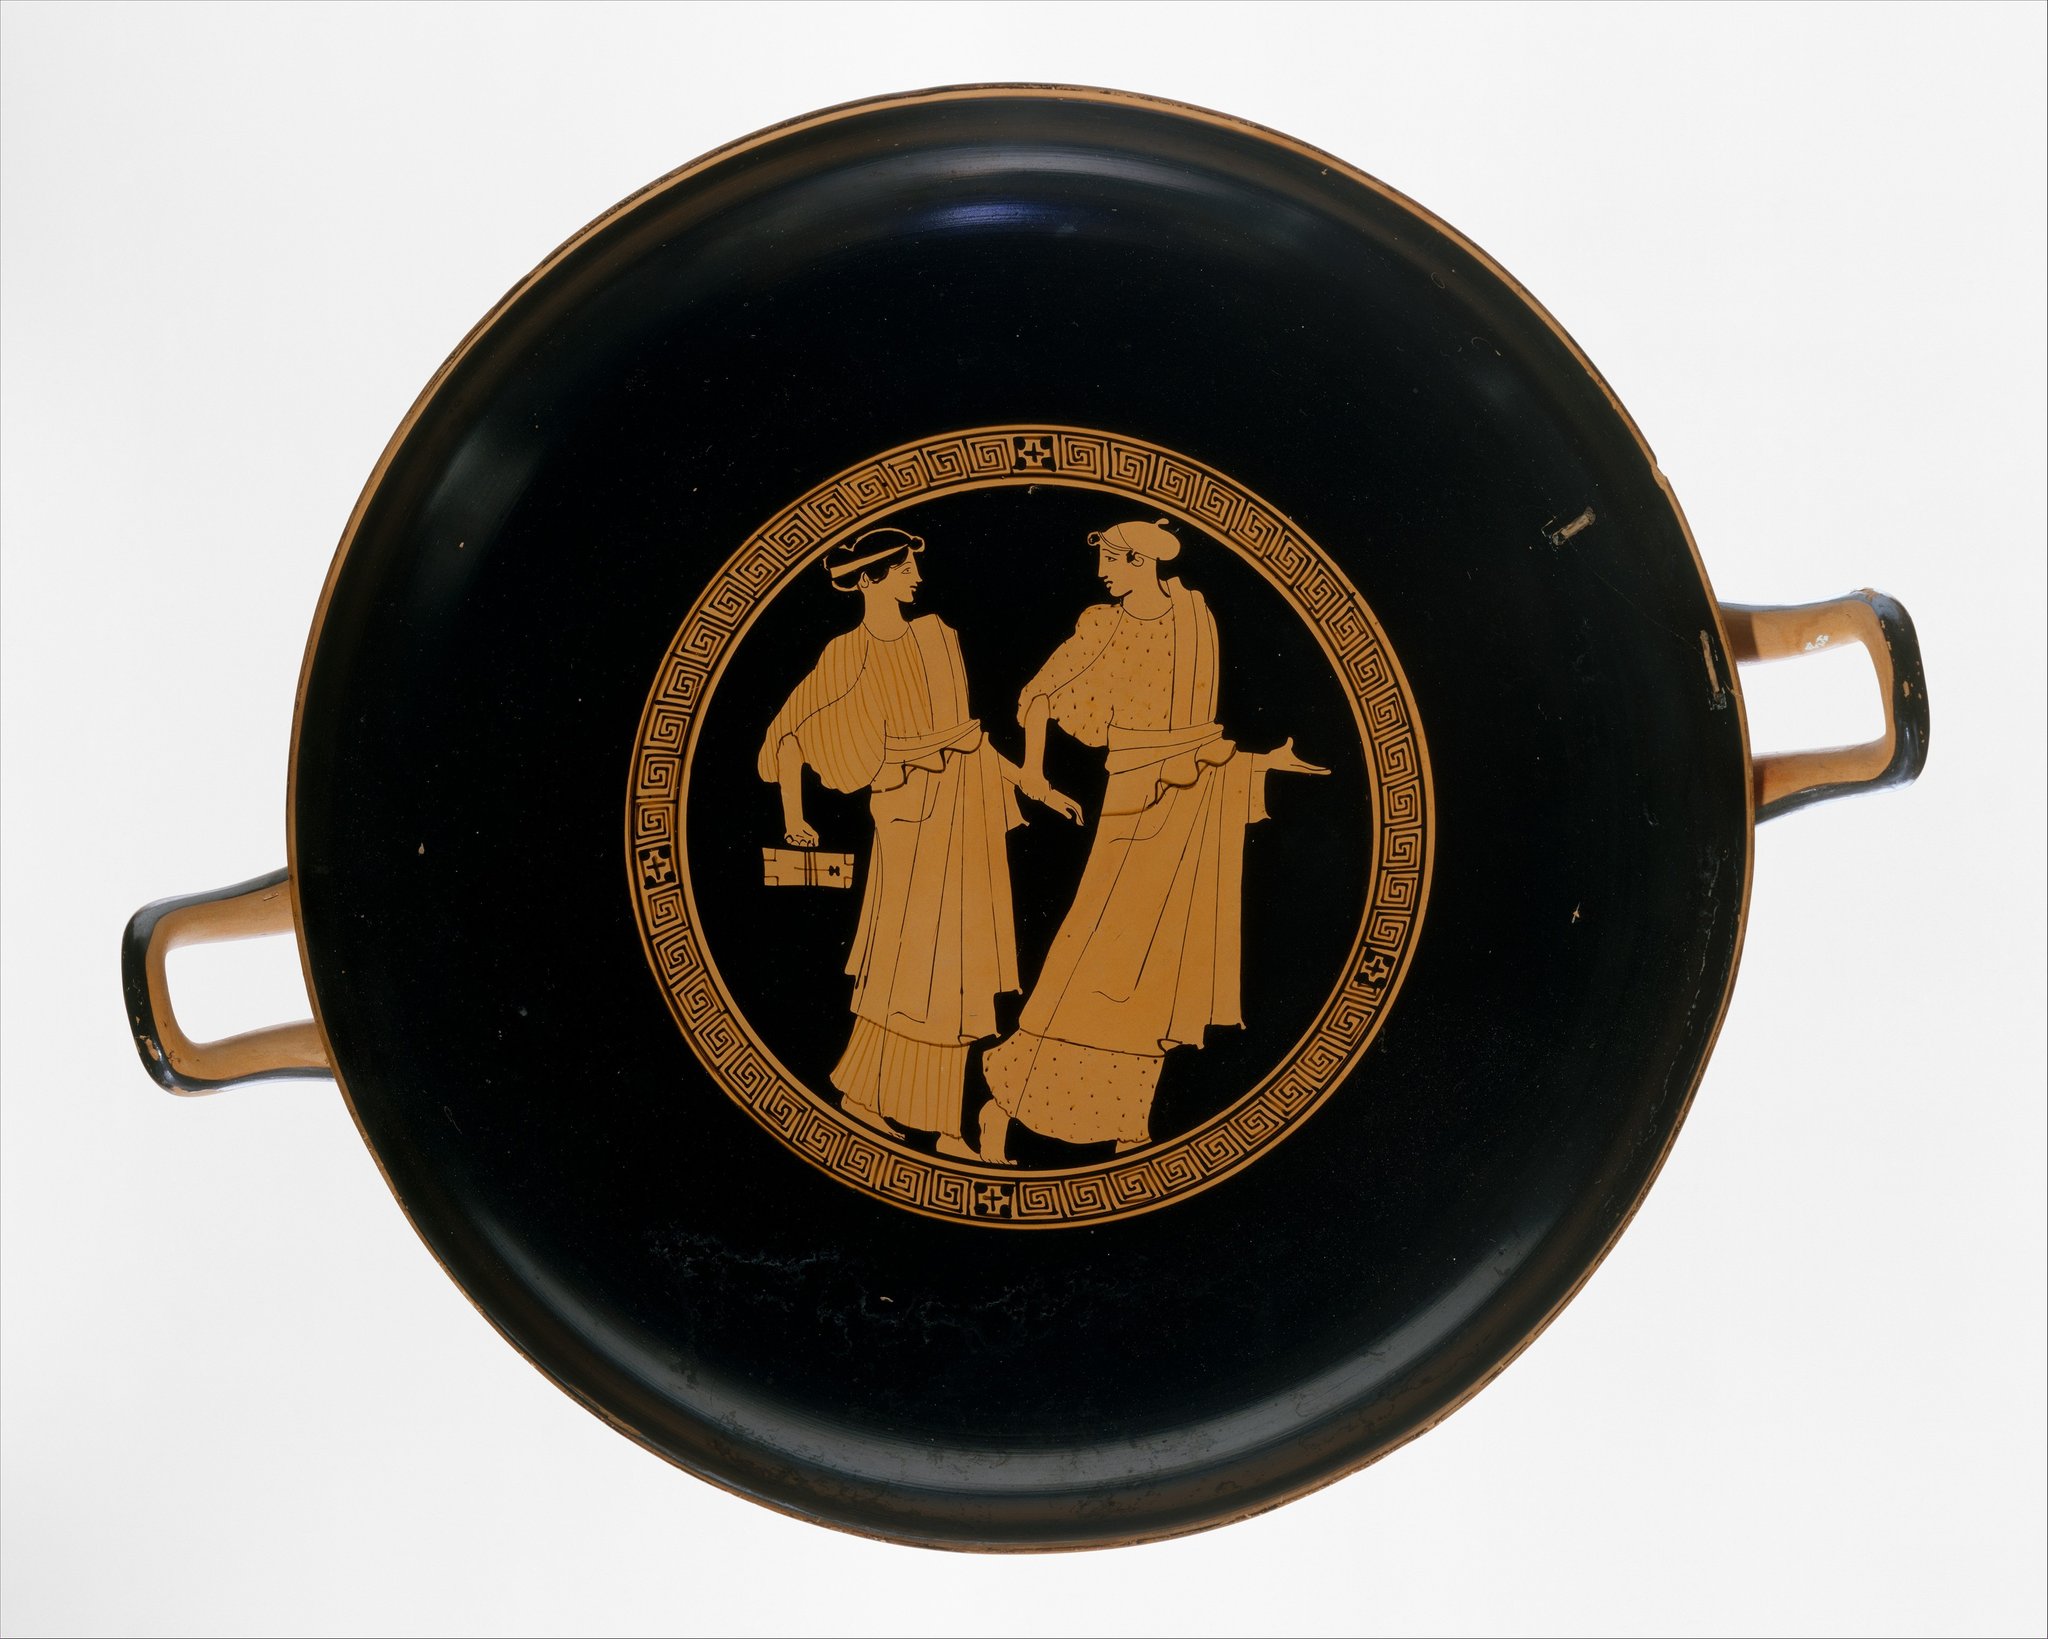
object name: kylix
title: Terracotta kylix (drinking cup)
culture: greek, attic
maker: painter of bologna 417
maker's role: artist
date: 460-450 BCE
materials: terracotta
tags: women